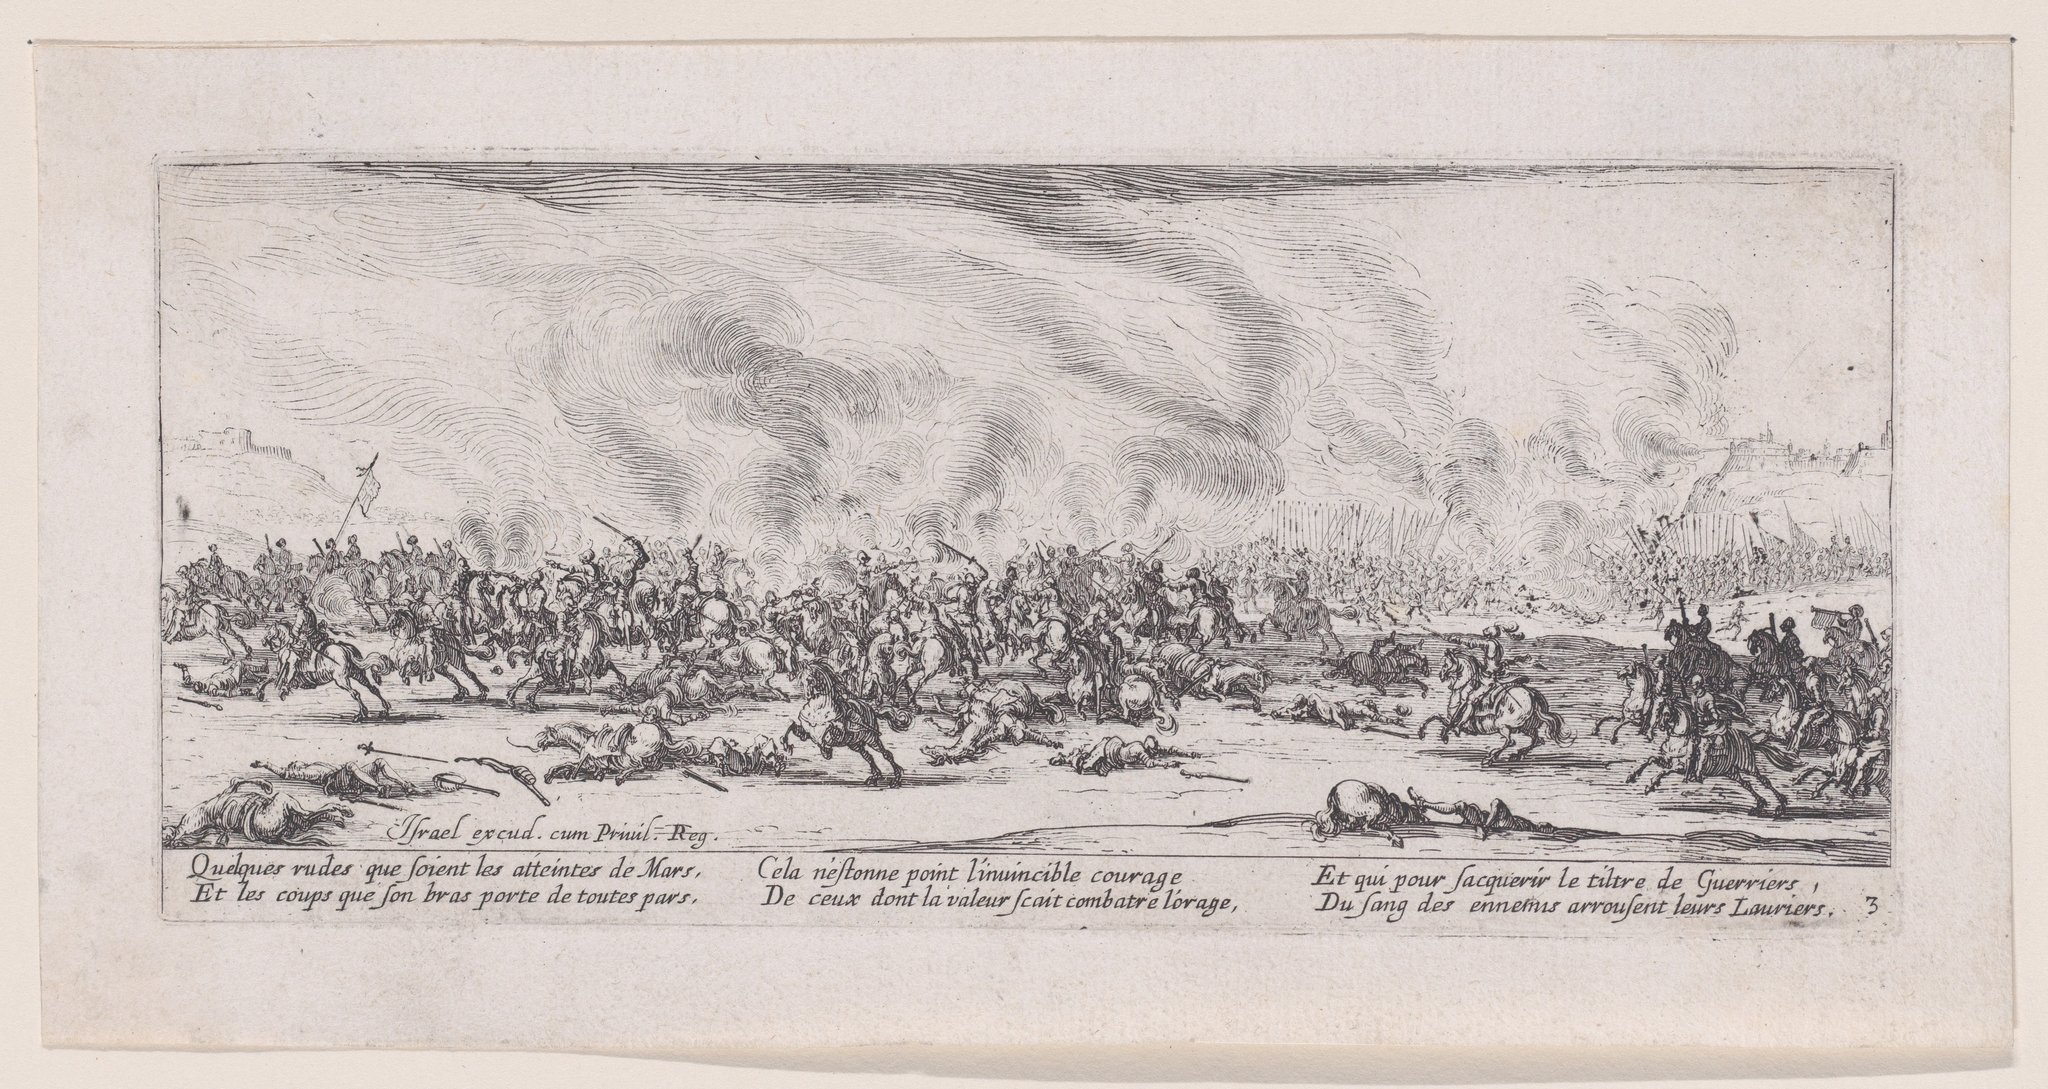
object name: print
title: La Bataille (The Battle), from Les Misères et les Mal-Heures de la Guerre (The Miseries and Misfortunes of War), plate 3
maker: jacques callot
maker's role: artist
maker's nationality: french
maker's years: 1592-1635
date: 1633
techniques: etching